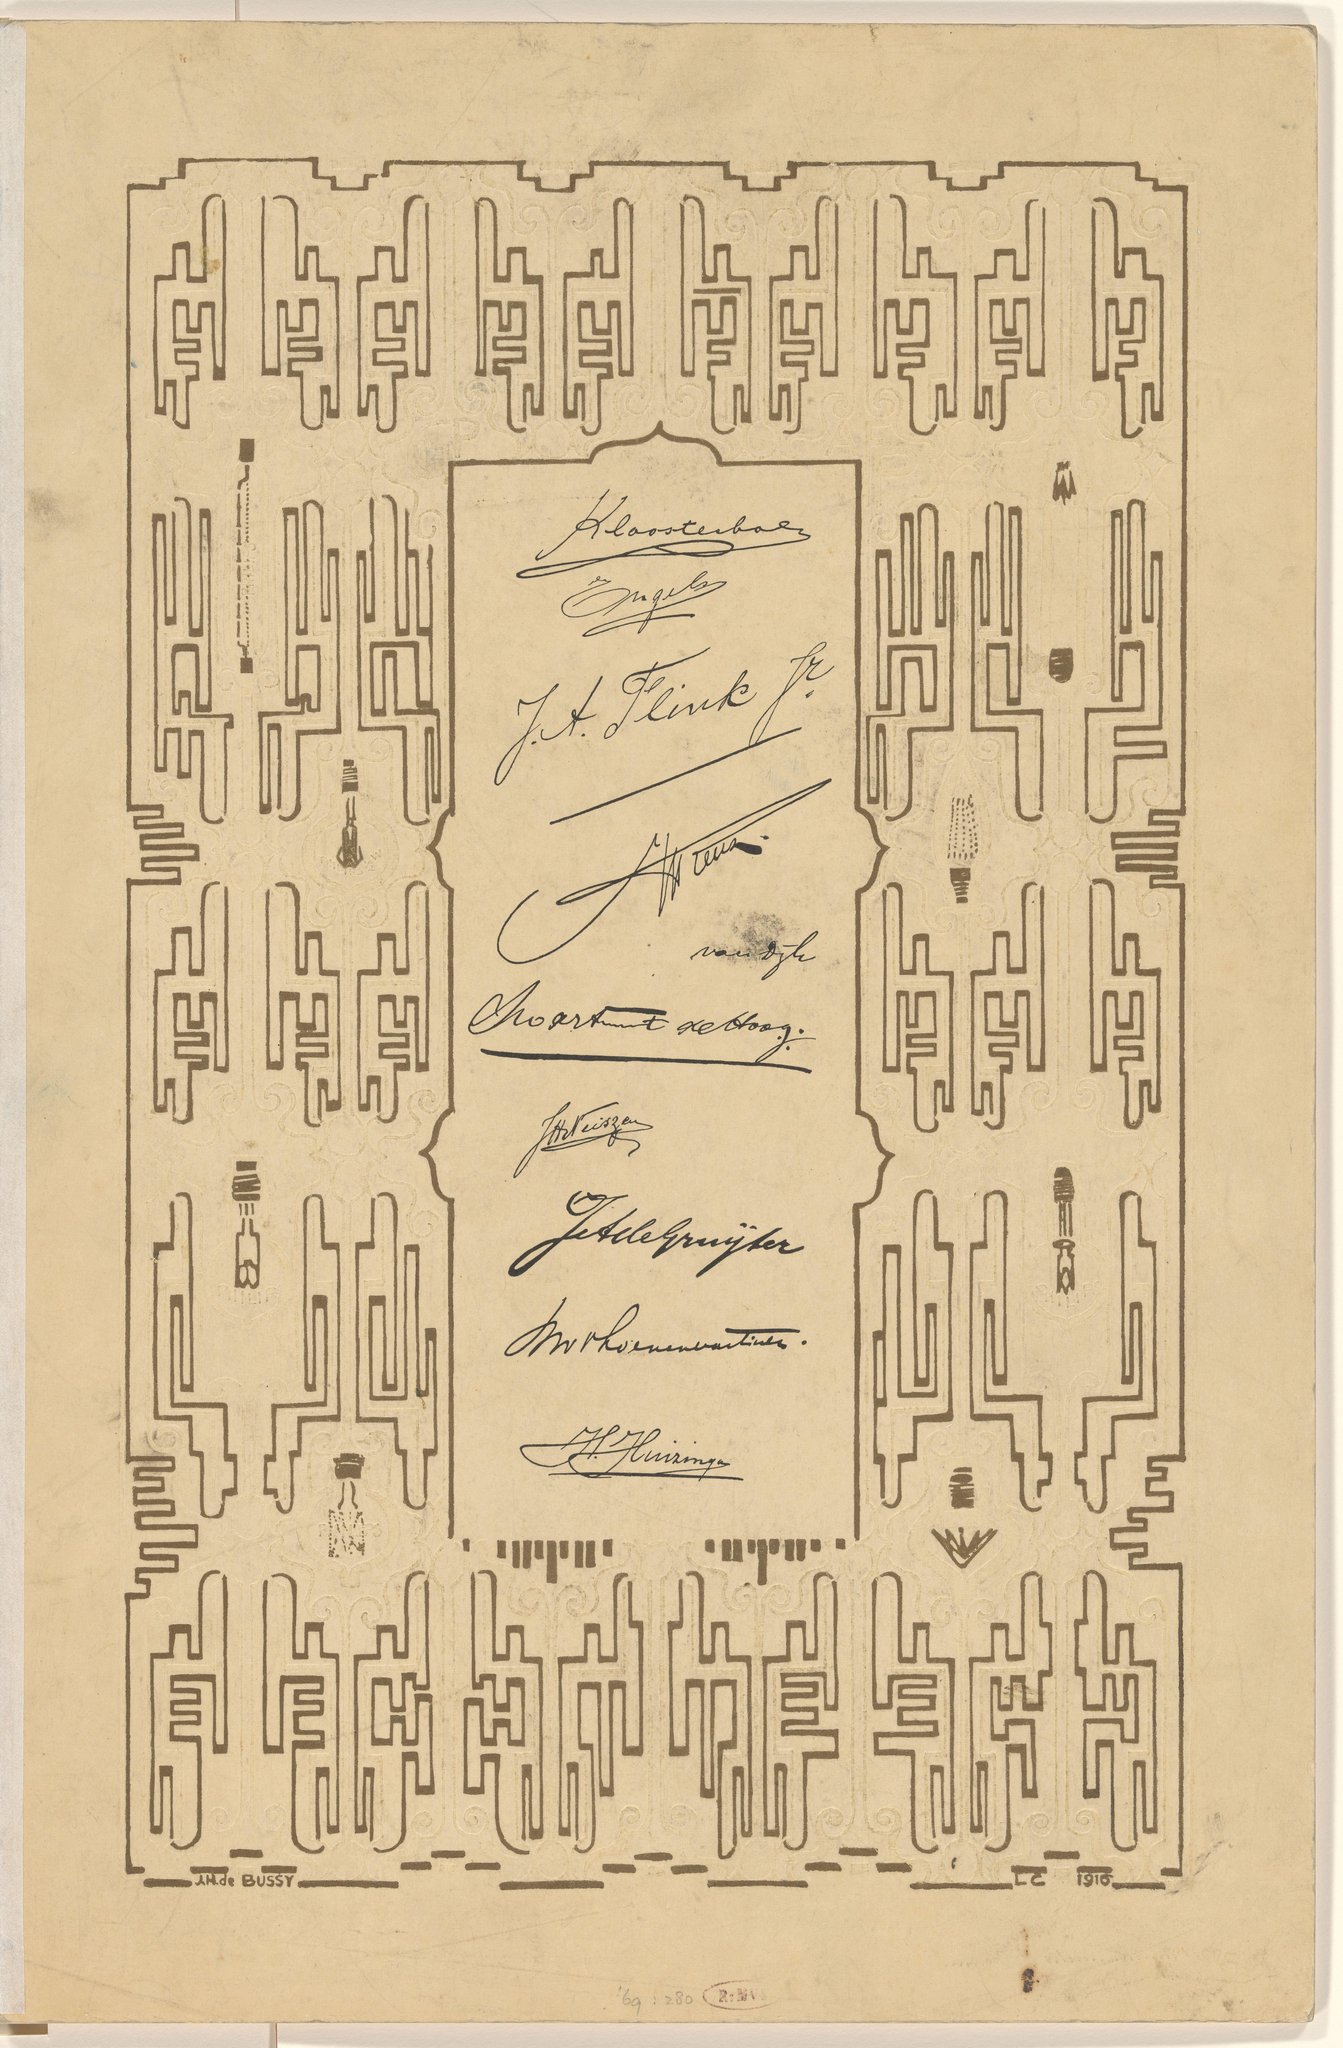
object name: print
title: Handtekeningenblad ter gelegenheid van het vijfentwintigjarig jubileum van de N.V. Philips Gloeilampenfabrieken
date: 1916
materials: cardboard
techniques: blind stamped, pen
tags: light bulb (electric), industries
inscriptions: collector's mark: Lugt 2228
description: Ornamentrand met gloeilampen. In het midden tien handtekeningen.